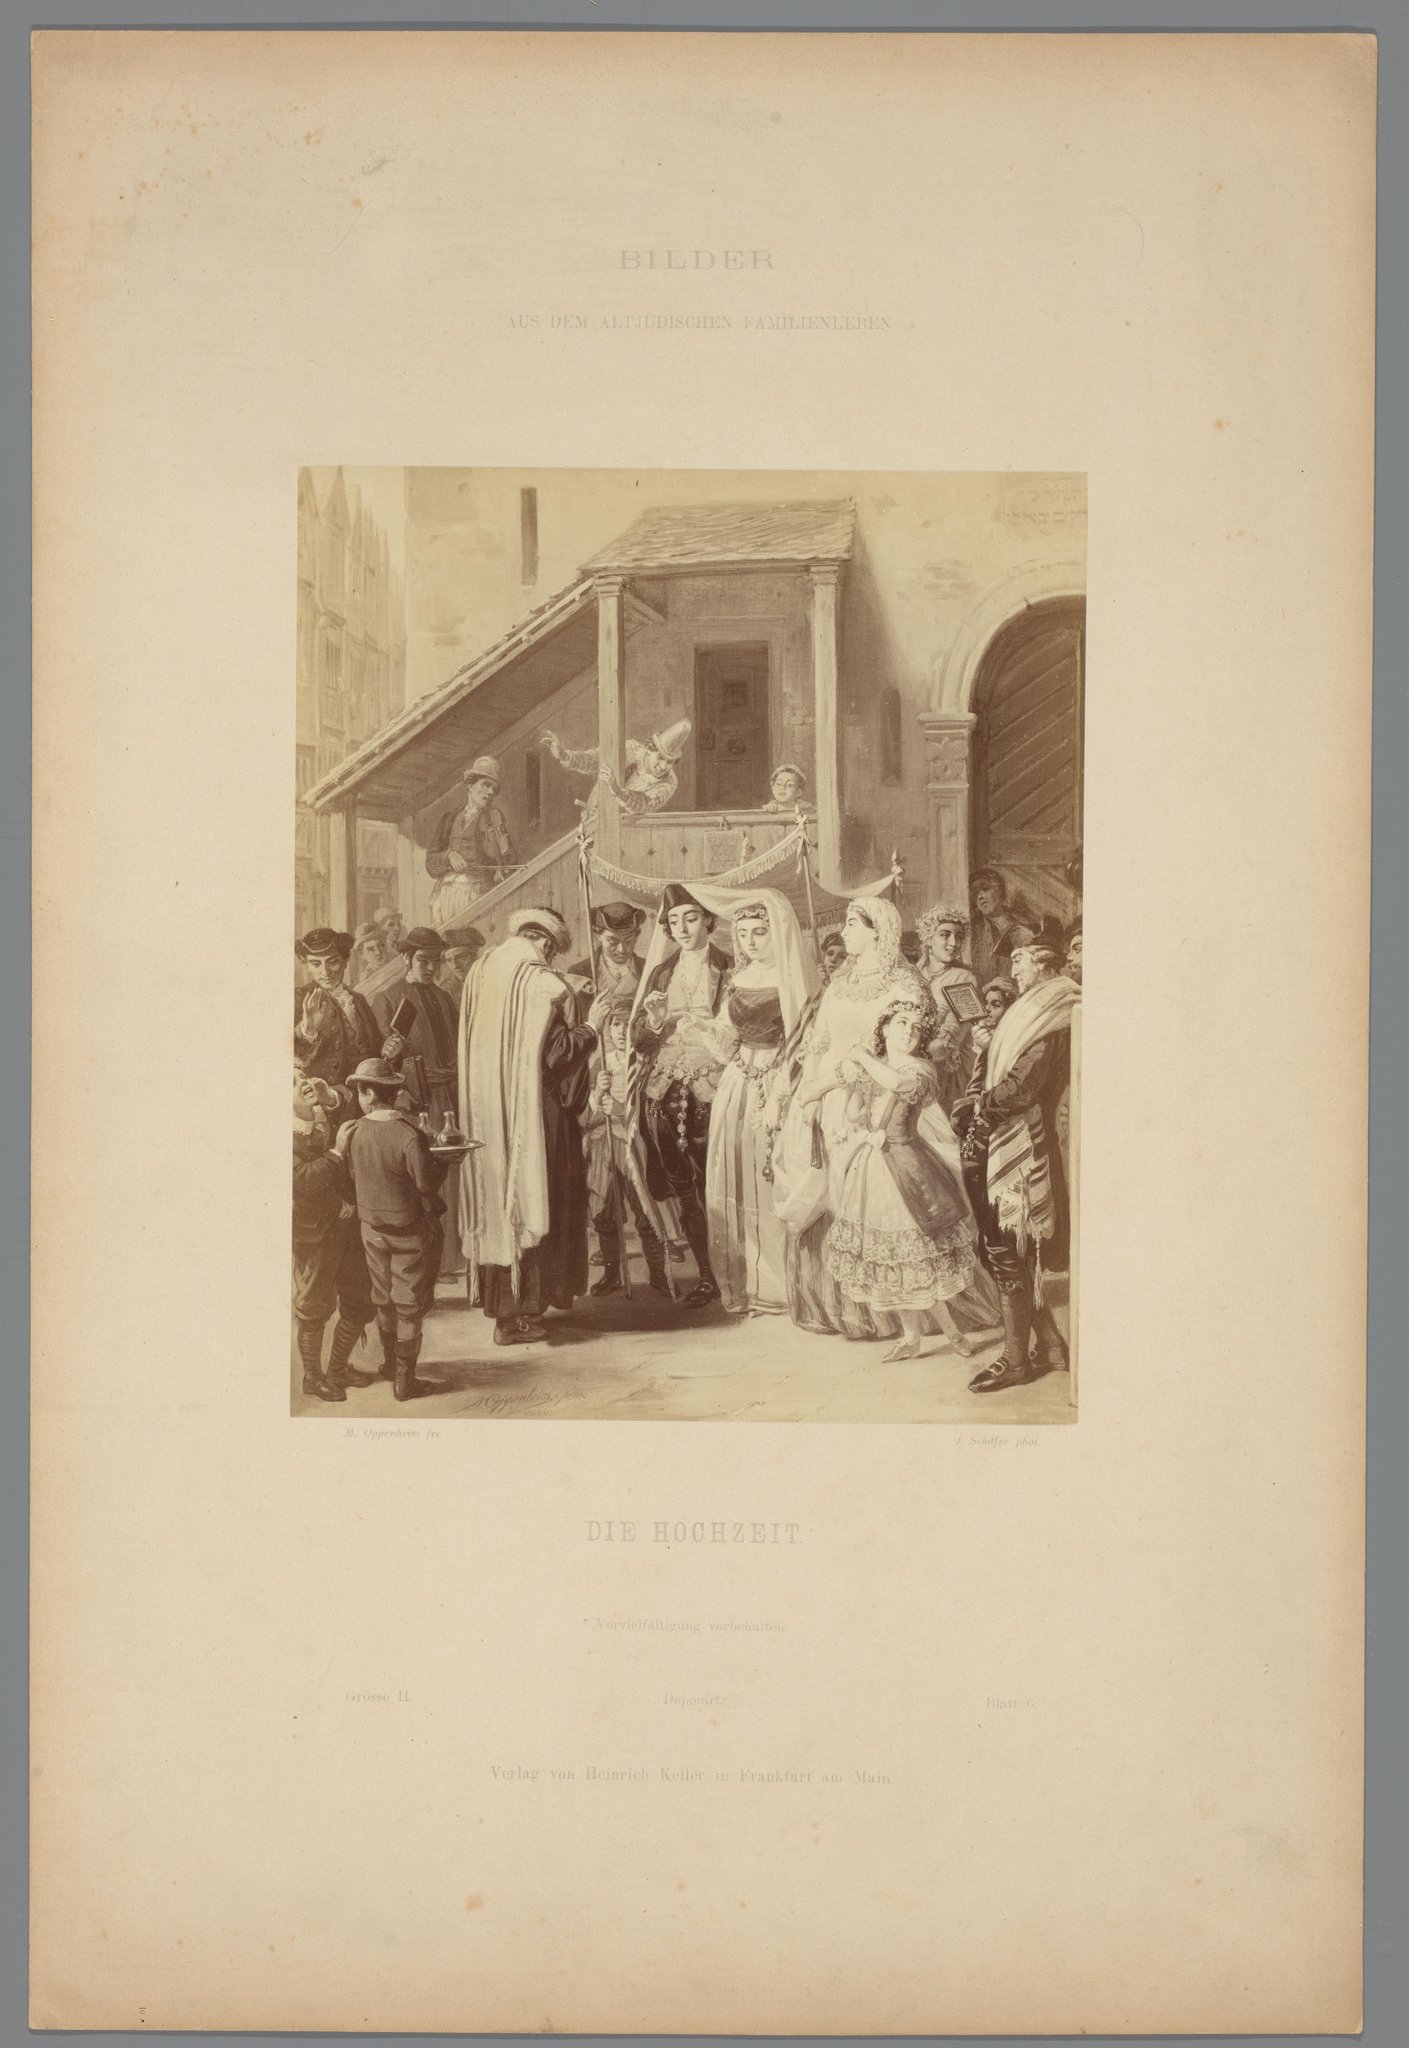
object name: reproduction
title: Fotoreproductie van Die Hochzeit door Moritz Daniel Oppenheim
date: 1866-1900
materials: cardboard, photographic support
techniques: albumen print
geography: frankfurt am main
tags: 'kiddushin', jewish wedding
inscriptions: inscription: ‘Vervielfältigung vorbehalten./ Grösse II - Deponirt - Blatt 6.’